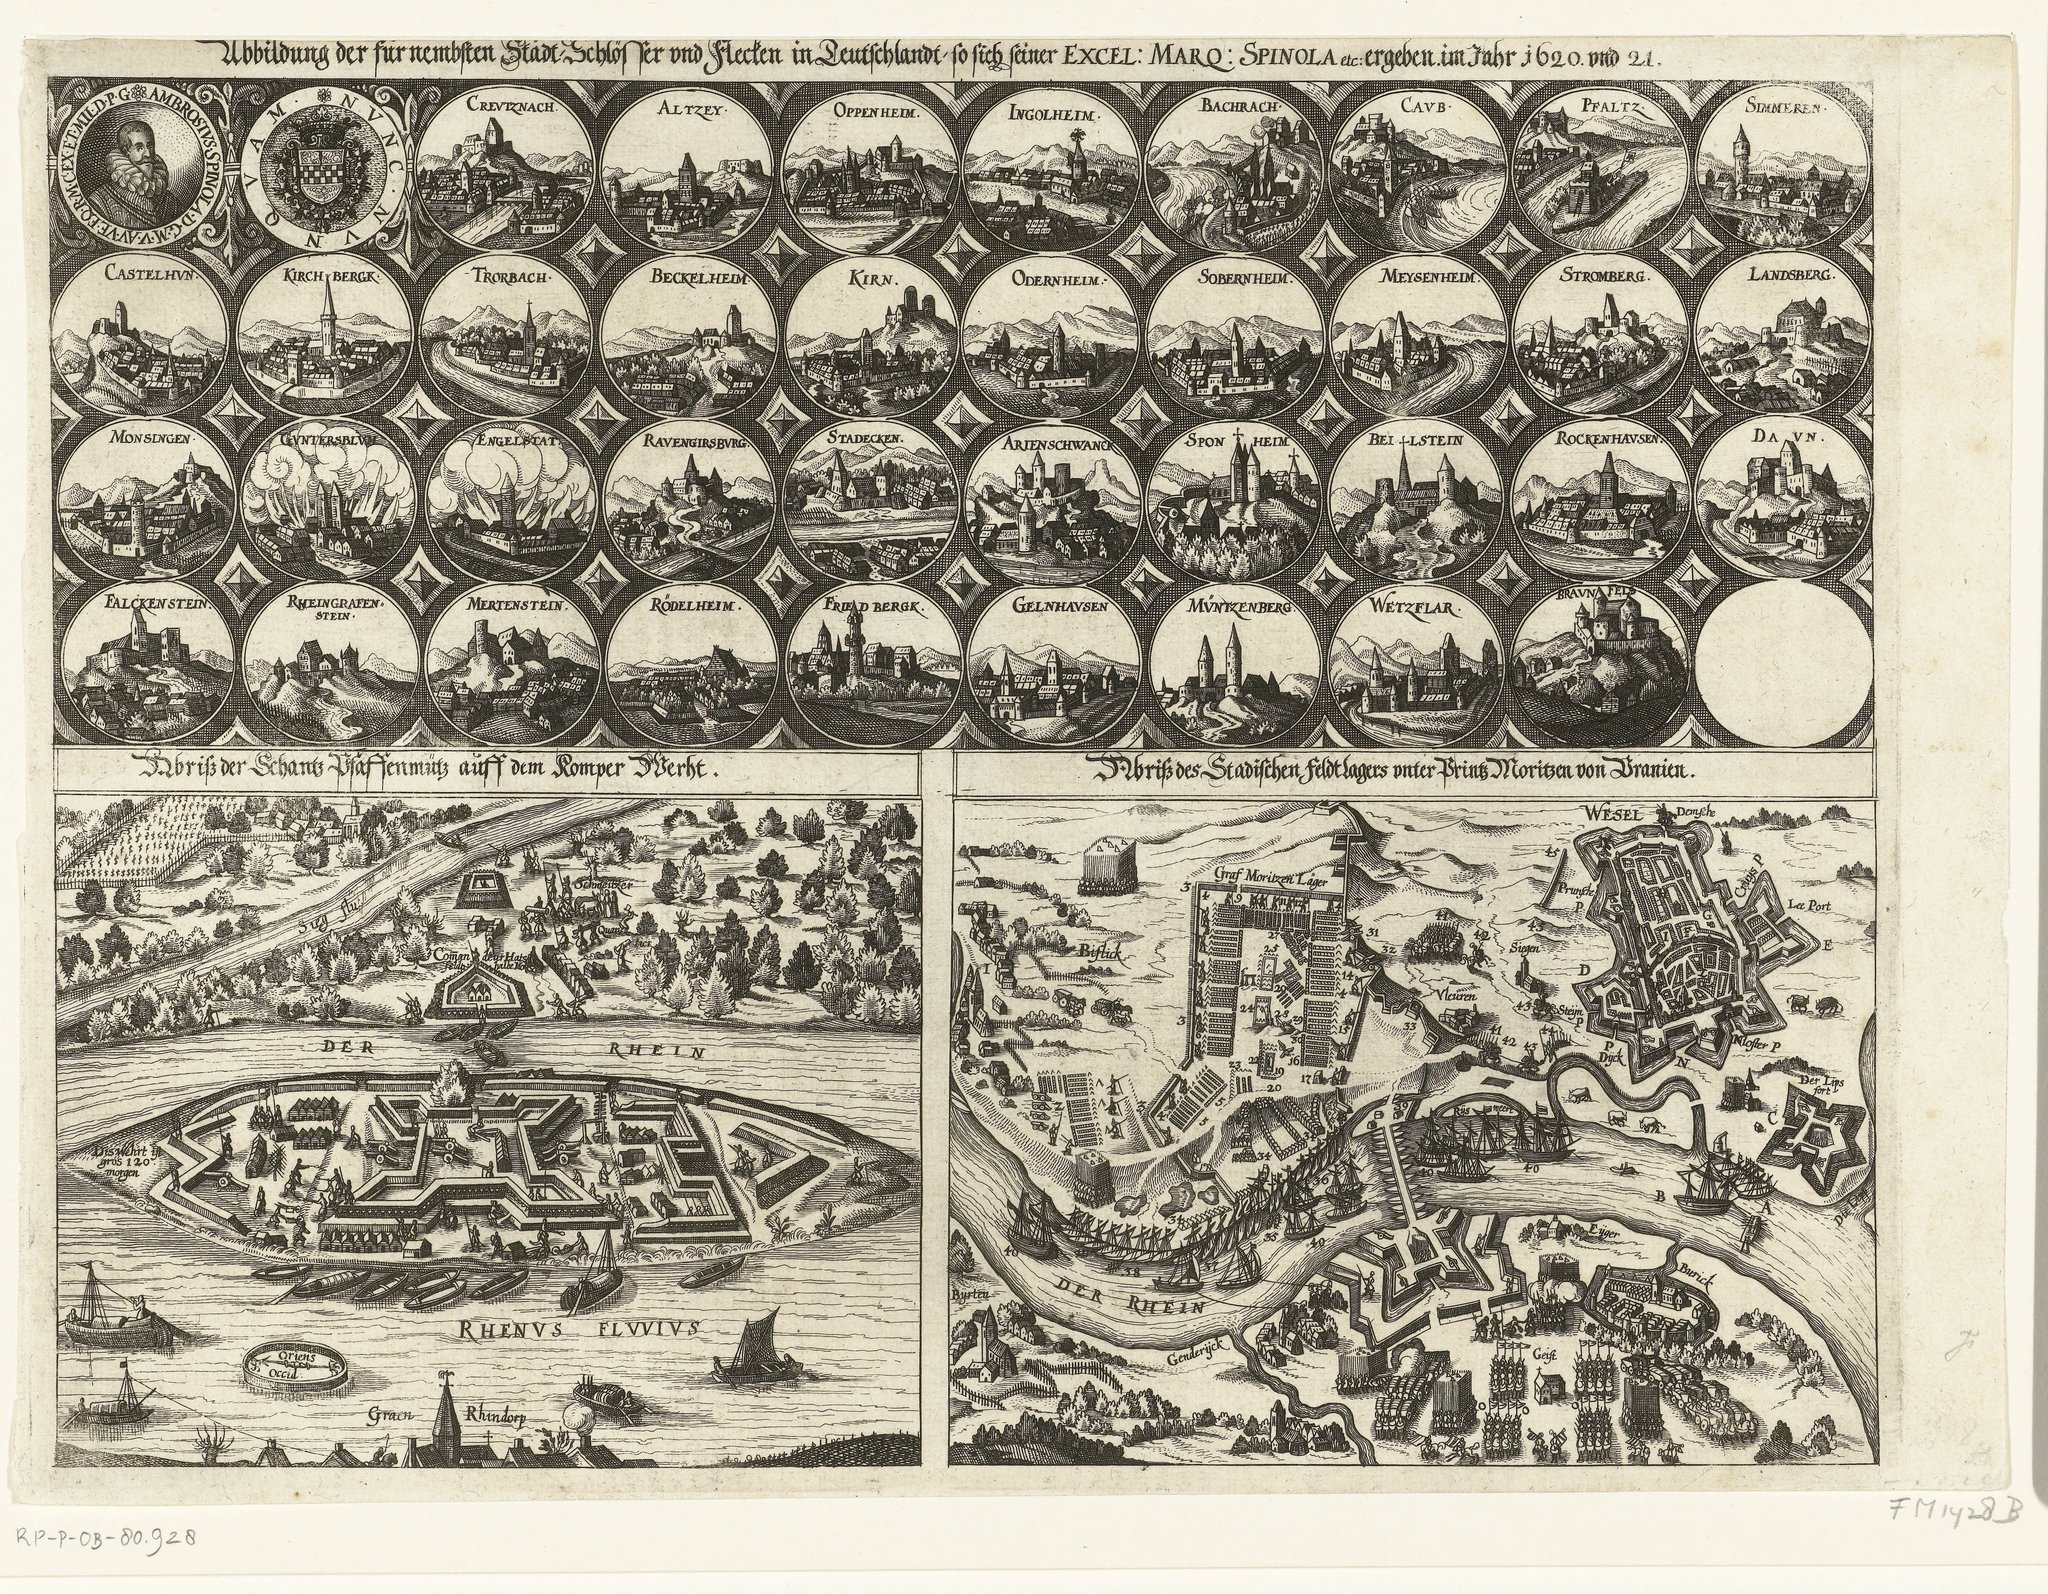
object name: print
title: Abbildung der fur nembsten Stadt, Schlösser und Flecken in Deutschlandt, so sich seiner Excel: Marq: Spinola etc. ergeben im Jahr 1620 und 21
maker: Anonymous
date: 1621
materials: paper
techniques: etching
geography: germany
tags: maps of separate countries or regions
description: Vier rijen met elk 10 medaillons met kleine plaatjes van de 37 door Spinola veroverde Duitse steden, kastelen en dorpen in de jaren 1620-1621. De bovenste rij begint met een portretje en het wapen van de markies. Hieronder twee aparte gezichten op de Schans Papenmuts en het leger van Maurits bij Wesel.